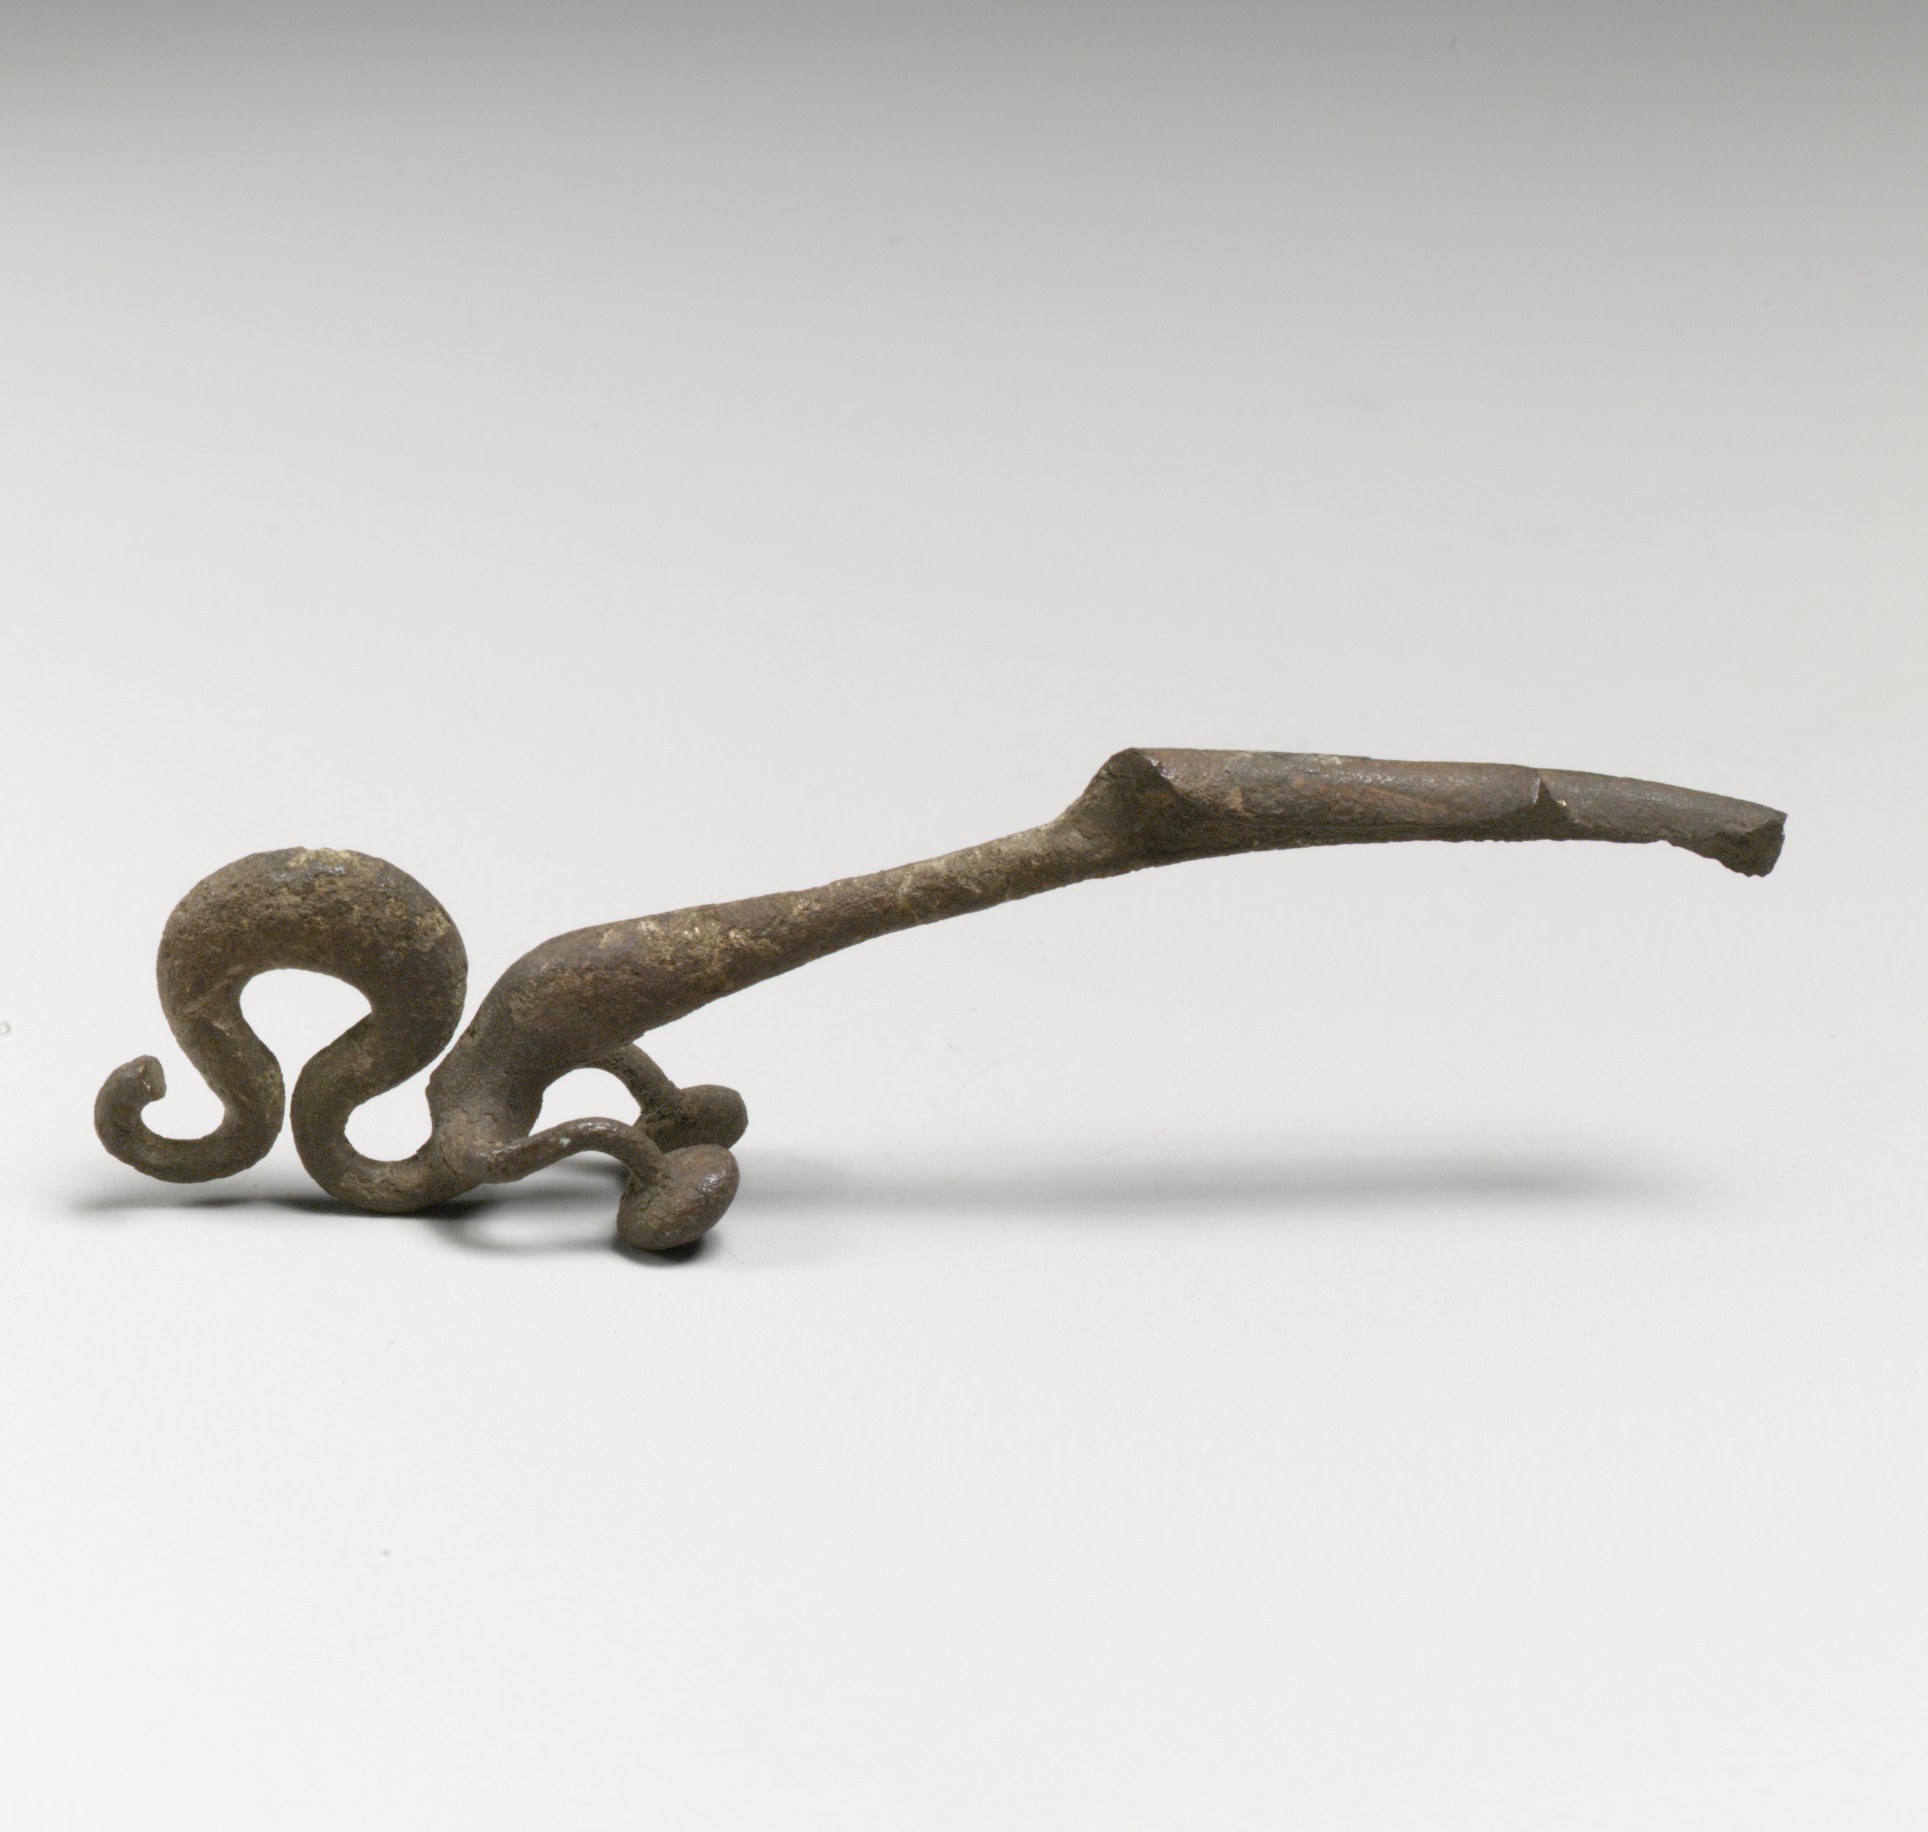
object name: fibula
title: Dragon-type fibula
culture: italic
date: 800-501 BCE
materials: bronze